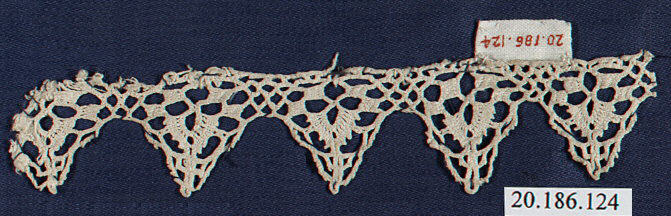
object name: insertion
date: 1501-1600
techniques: lace